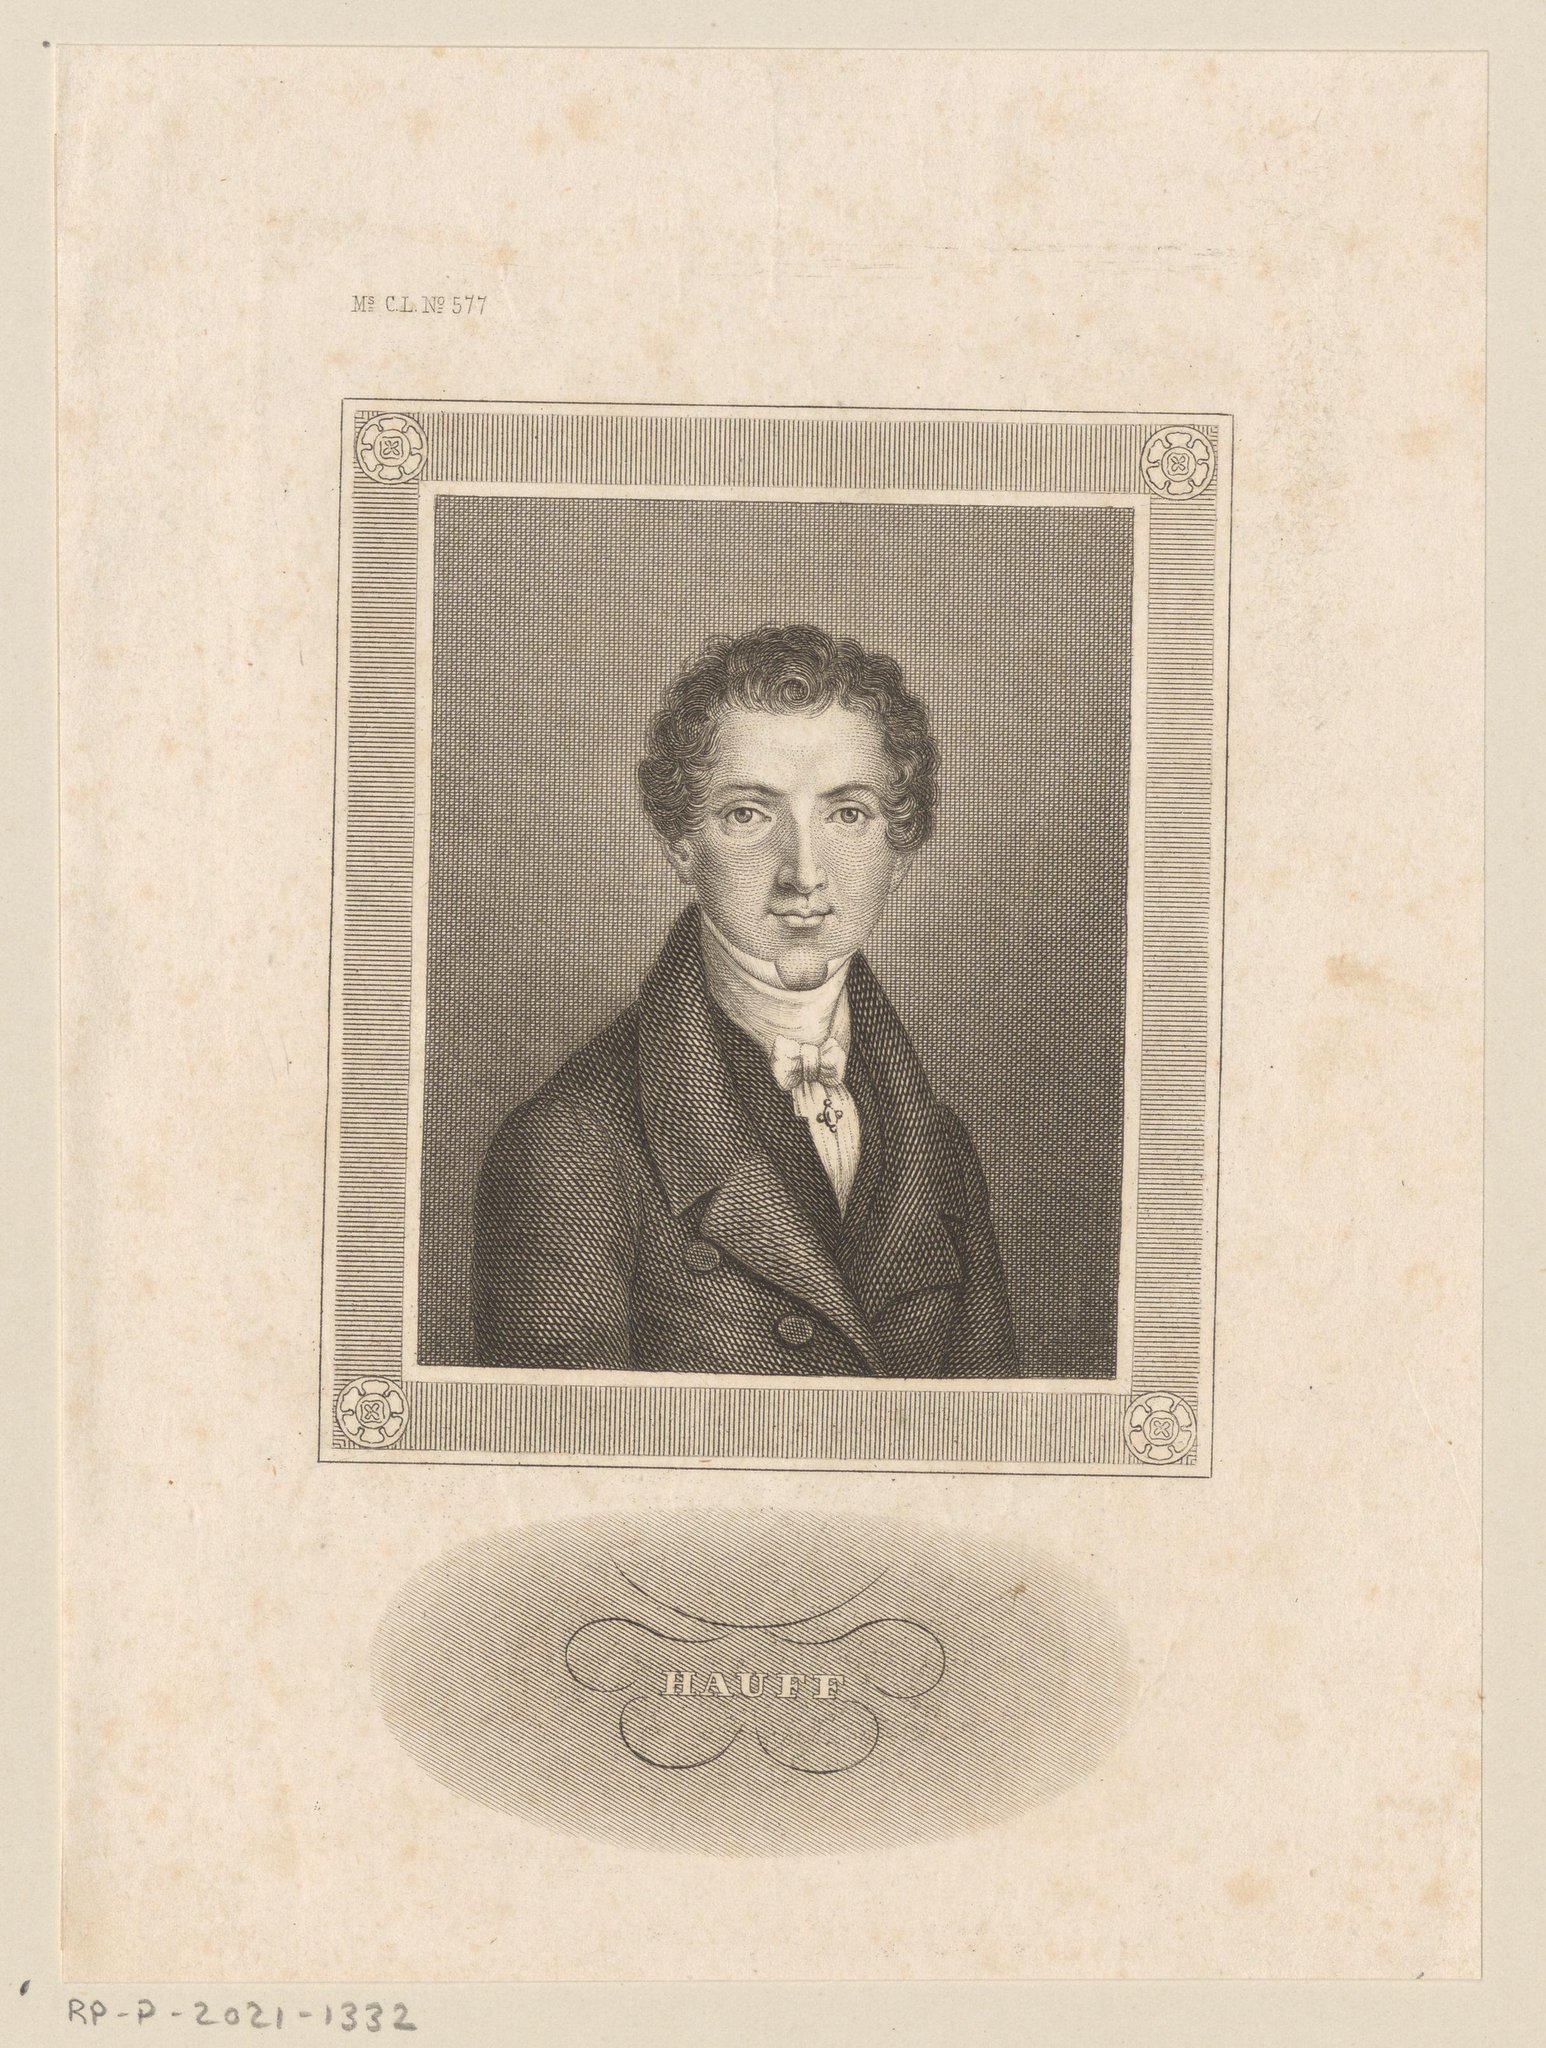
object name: book illustration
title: Portret van Wilhelm Hauff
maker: Anonymous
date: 1840-1855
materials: paper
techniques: engraving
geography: hildburghausen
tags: wilhelm hauff, historical persons, portrait of a writer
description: Prent uit: Meyer, Joseph. Das Grosse Conversations-Lexikon für die gebildeten Stände. Hildburghausen: Bibliographisches Institut, 1840-1855.